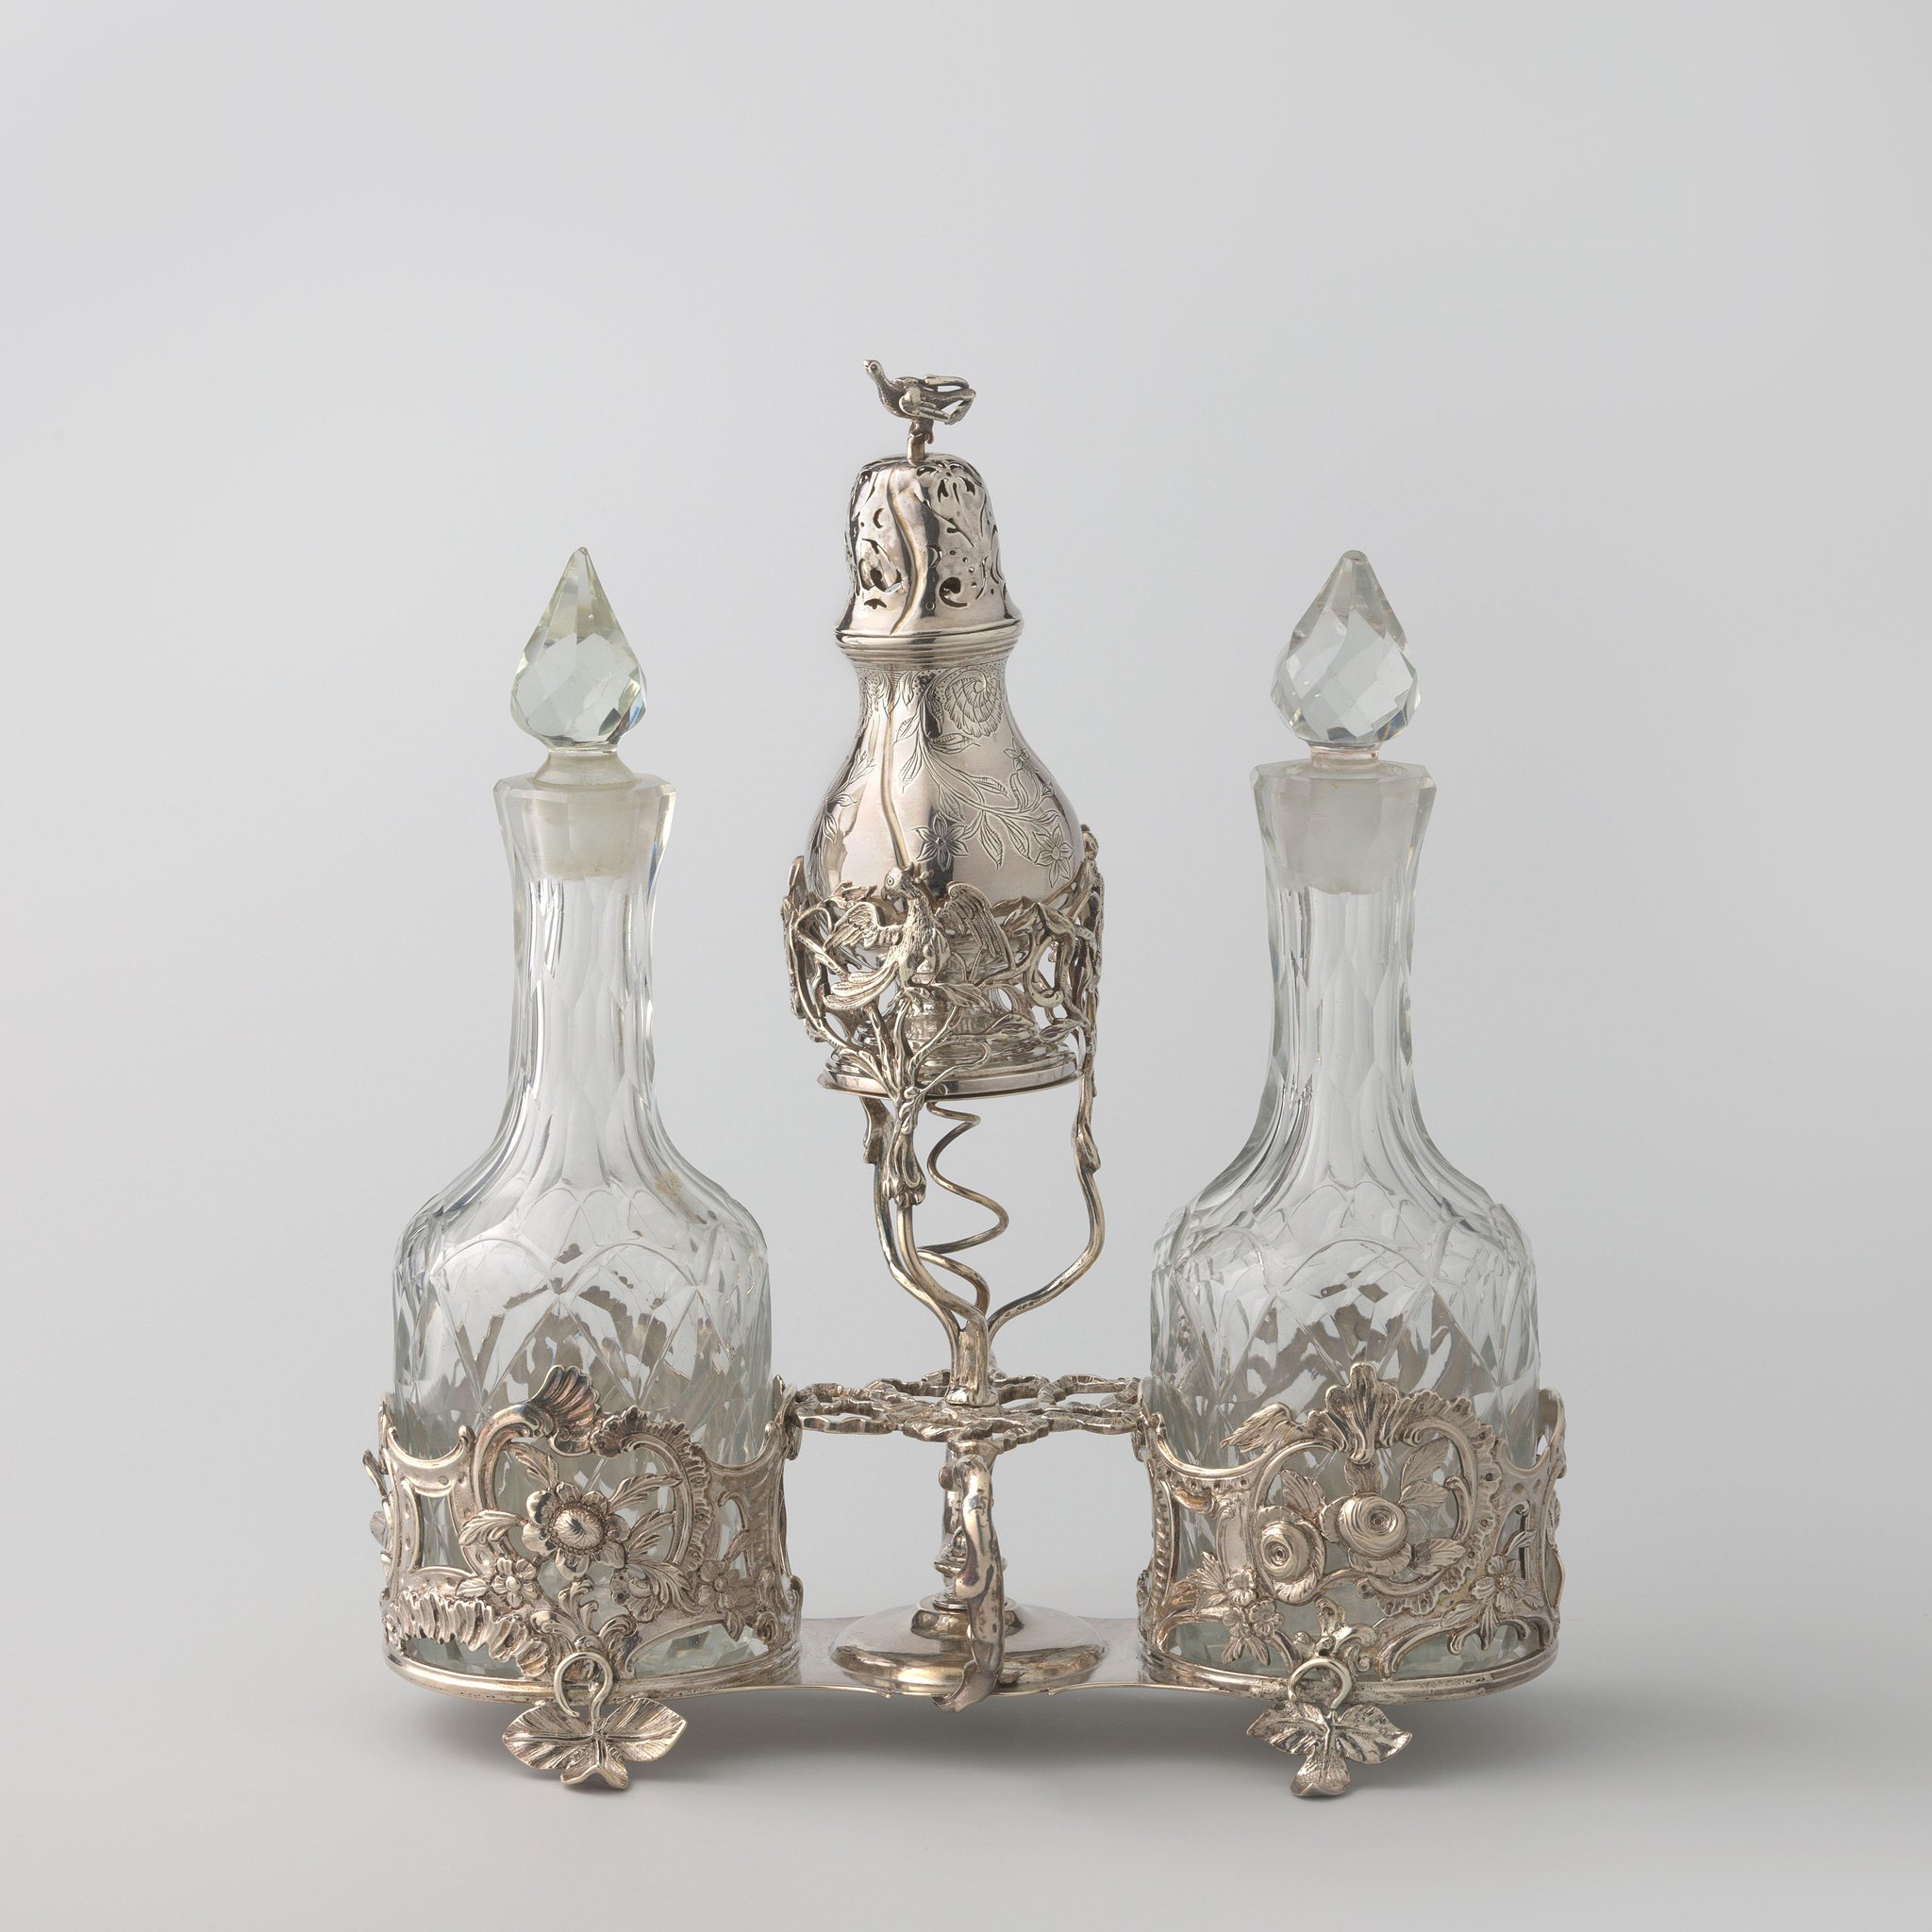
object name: peperbus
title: Zilveren peperbus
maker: wijnand warneke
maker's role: silversmith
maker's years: 1738-1810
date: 1767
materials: silver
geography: amsterdam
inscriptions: date letter: ‘H’, maker's mark, duty mark, alloy mark, town mark, duty mark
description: De getordeerde, peervormige peperbus heeft een geprofileerde, ingesnoerde voet en een los, opengewerkt deksel. Het lichaam wordt aan de bovenzijde, waar het iets uitloopt, omgeven door een profielrand. Het is gegraveerd met uit rocailles neerdalende bloementakken. Het deksel wordt bekroond door een vogel op een bladertakje. De peperbus behoord bij een olie- en azijnstel van zilver.